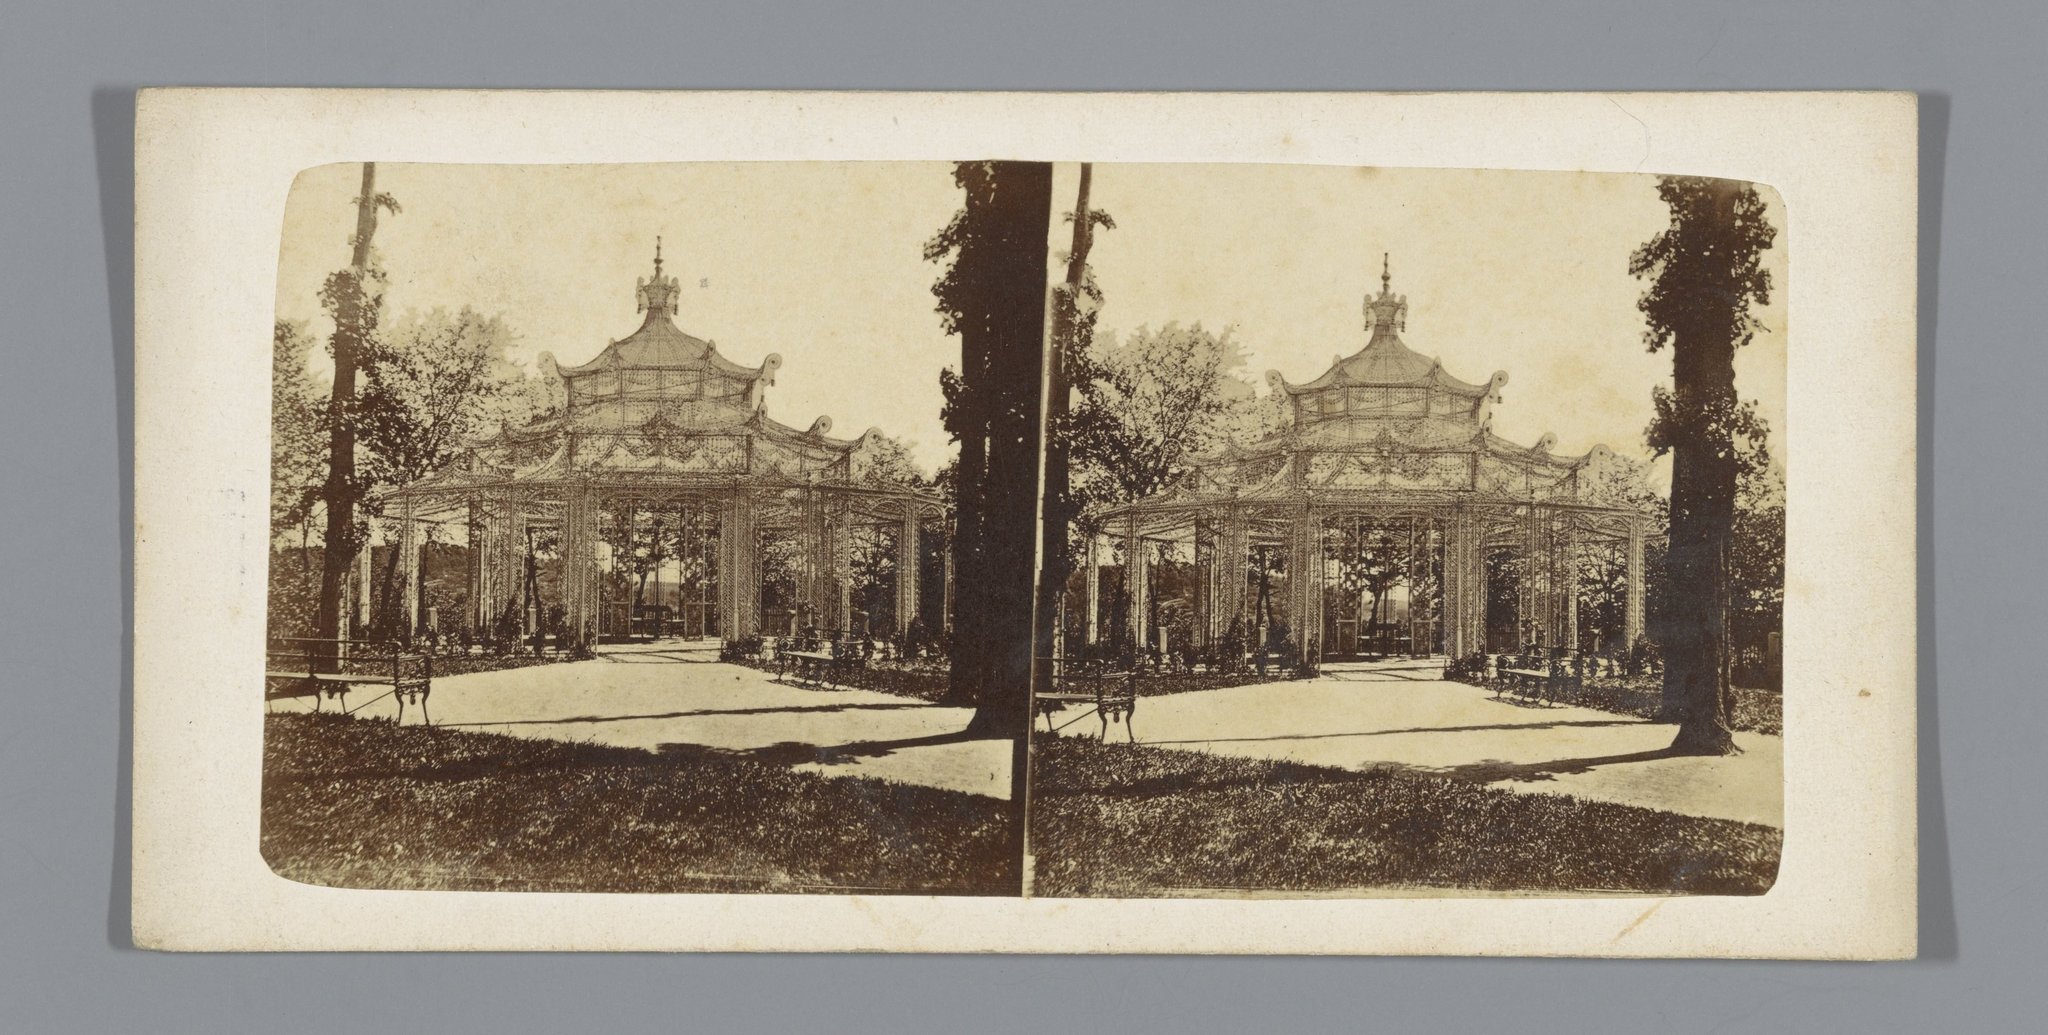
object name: stereograph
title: Paviljoen in de tuin van het Kurhaus te Bad Homburg vor der Höhe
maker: Anonymous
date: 1855-1865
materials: cardboard, photographic support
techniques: albumen print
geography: bad homburg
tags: garden, garden ornaments